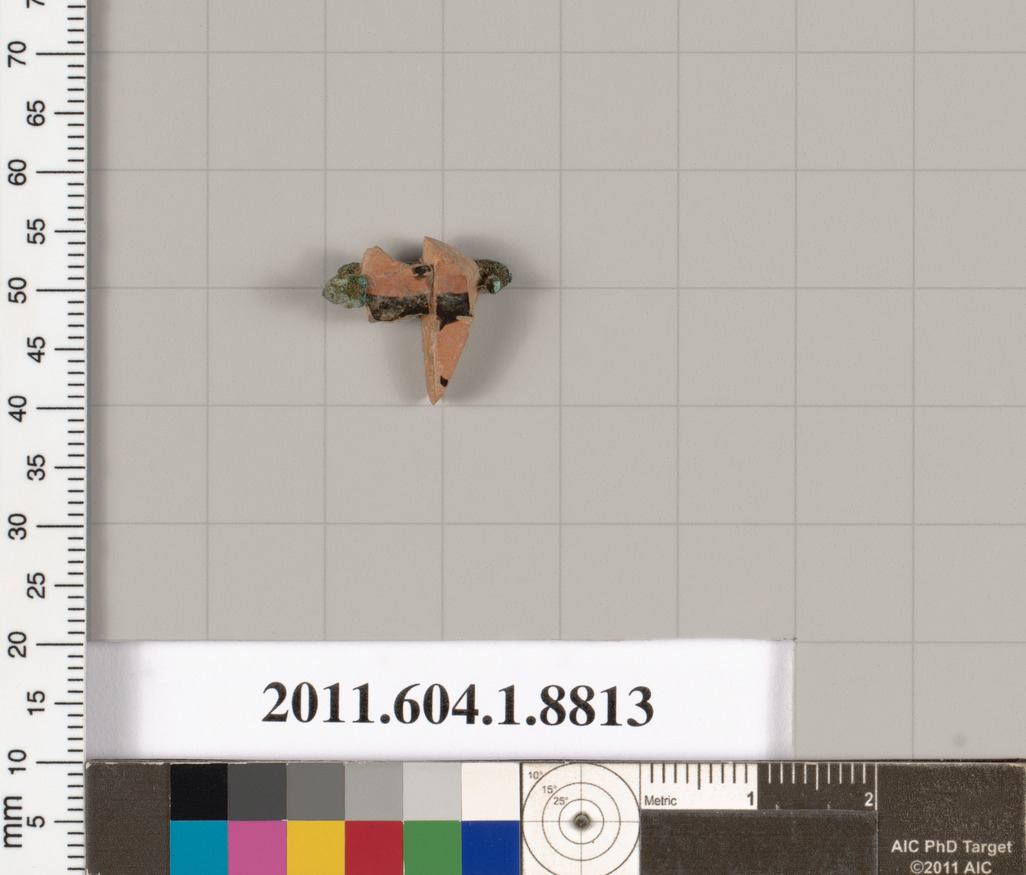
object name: kylix fragment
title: Terracotta fragment of a kylix (cup)?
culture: greek, attic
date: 480-470 BCE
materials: terracotta